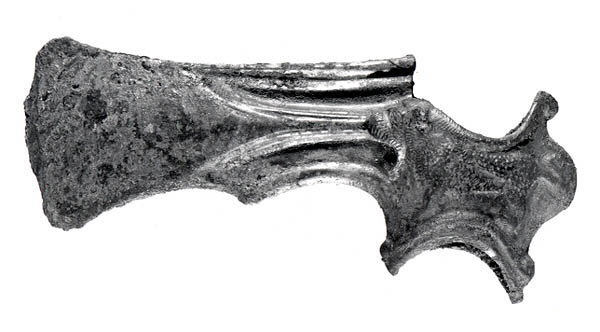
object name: axe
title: Shaft-hole axe head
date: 2333-1668 BCE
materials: bronze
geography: mesopotamia or western iran